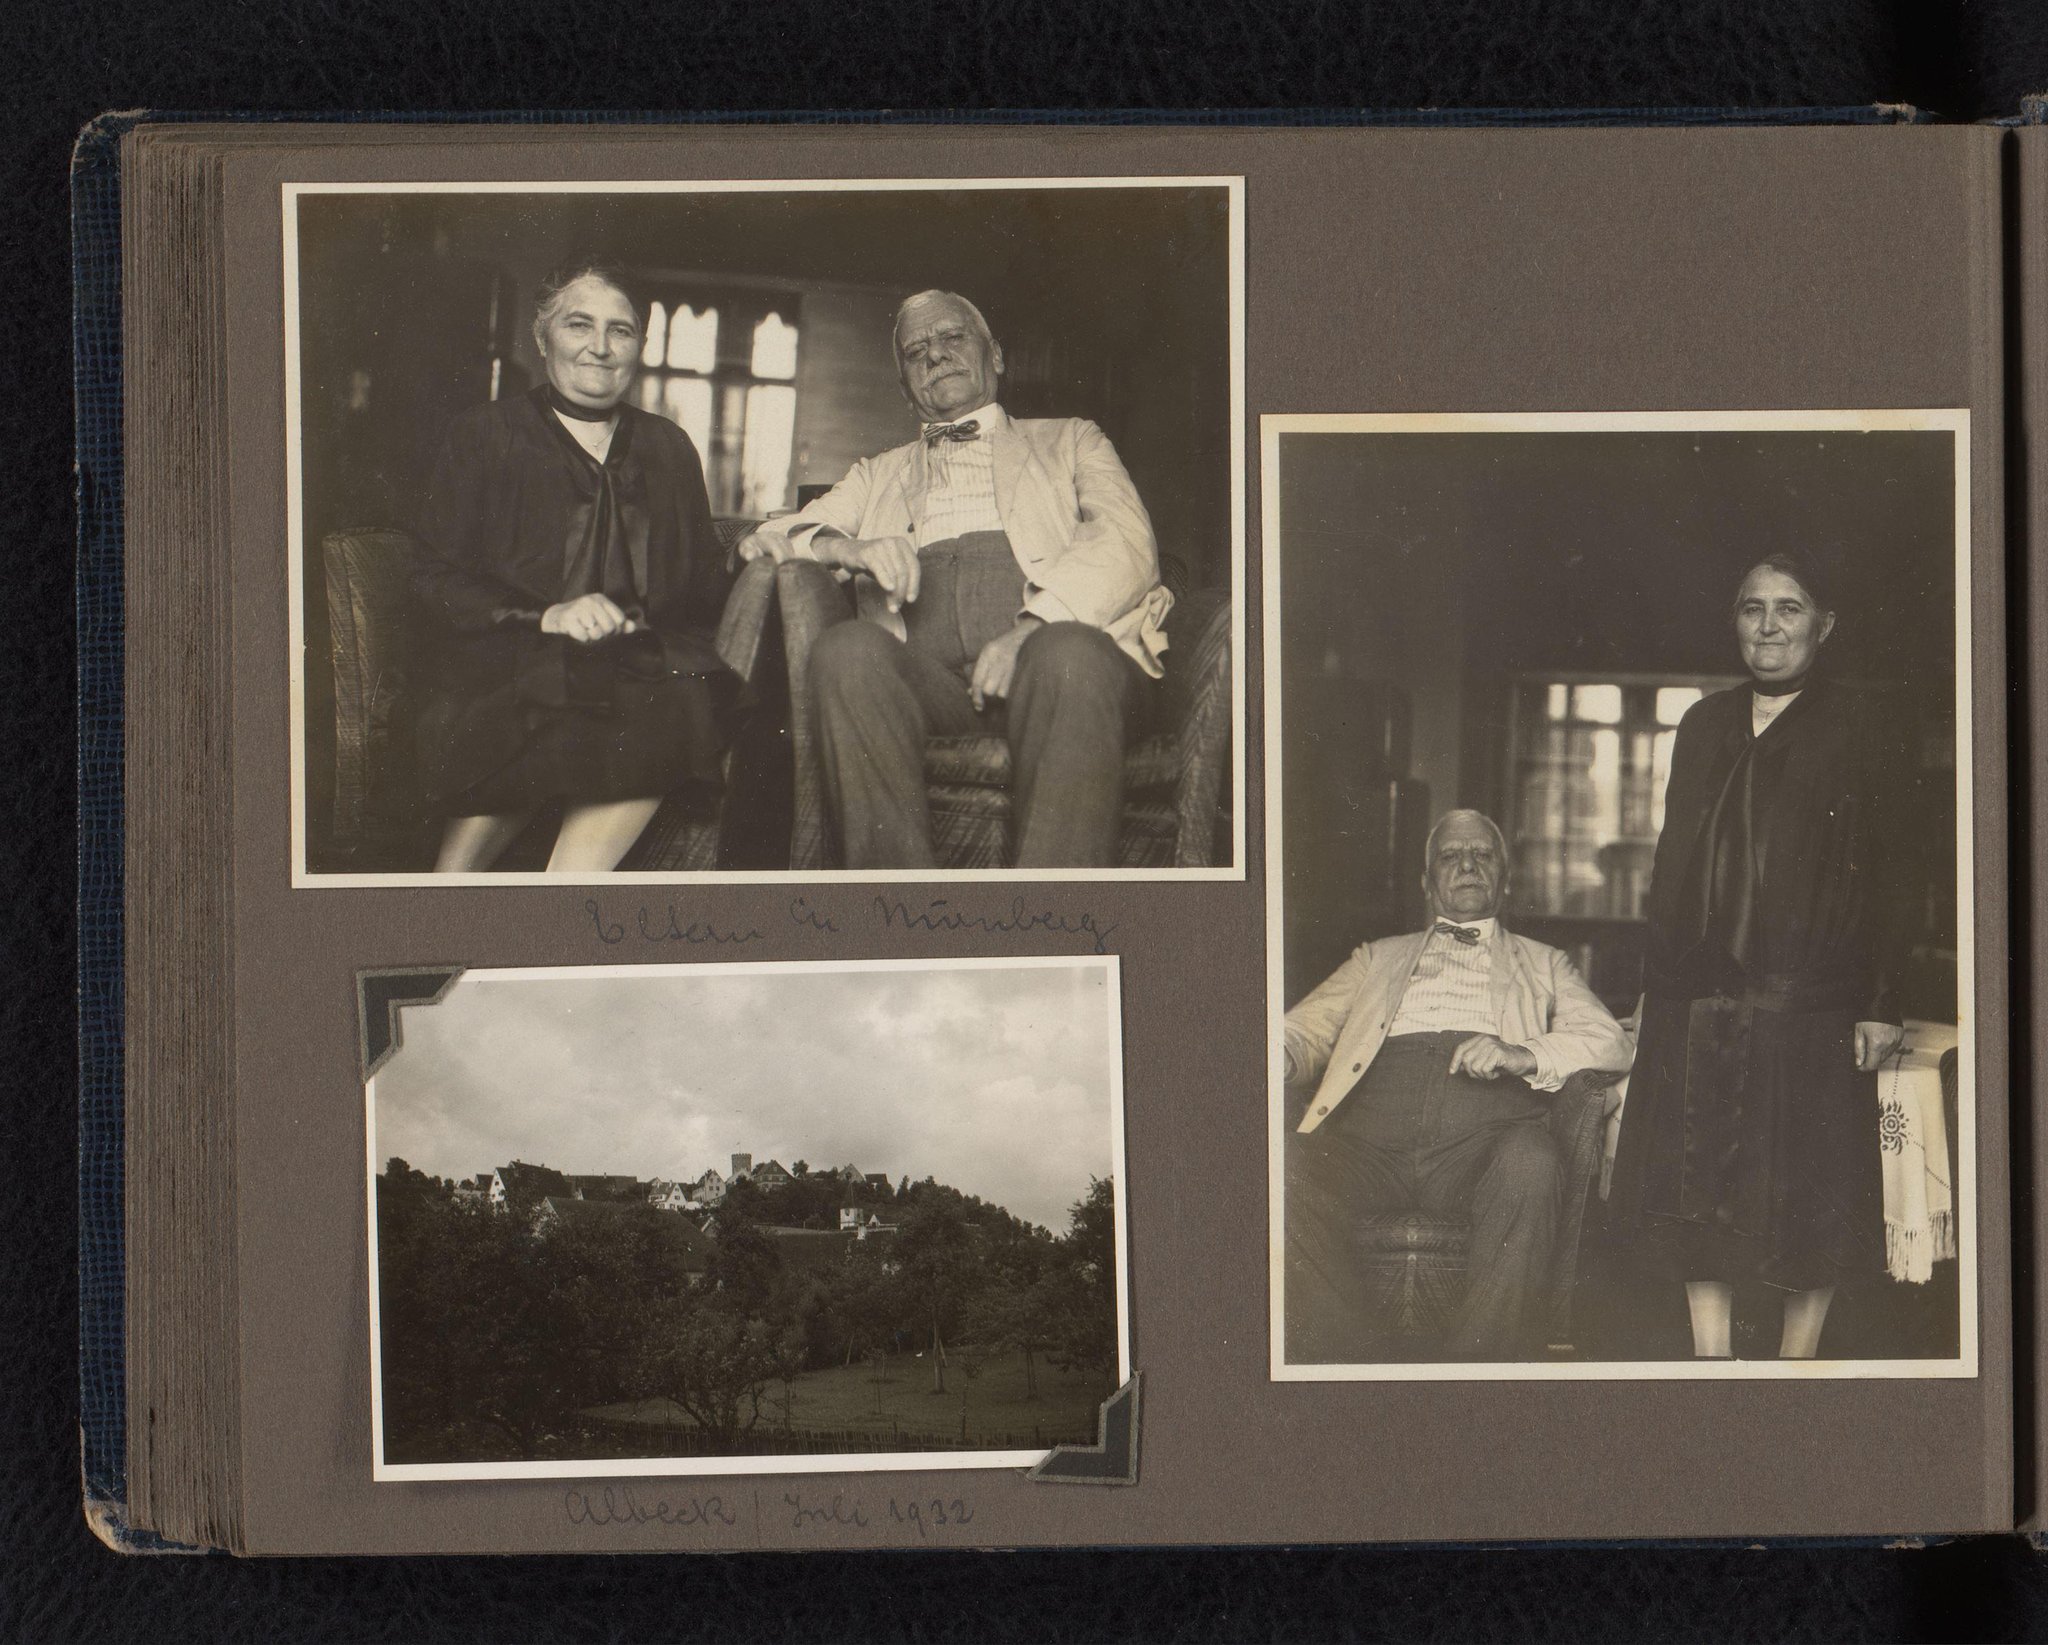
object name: album leaf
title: Meir Wachenheimer en zijn echtgenote Mathilde Wachenheimer-Wertheimer in huiselijke setting en zicht op Albeck, juli 1932, Neurenberg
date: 1907-1932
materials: paper, photographic support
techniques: gelatin silver print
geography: nuremberg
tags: city-view in general; 'veduta', austria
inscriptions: inscription: ‘Eltern in Nürnberg / Albeck Juli 1932’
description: Albumblad bevat drie foto's van Meir Wachenheimer en Mathilde Wachenheimer-Wertheimer. Uit album half formaat, blauw kunstlederen omslag met koordbinding.